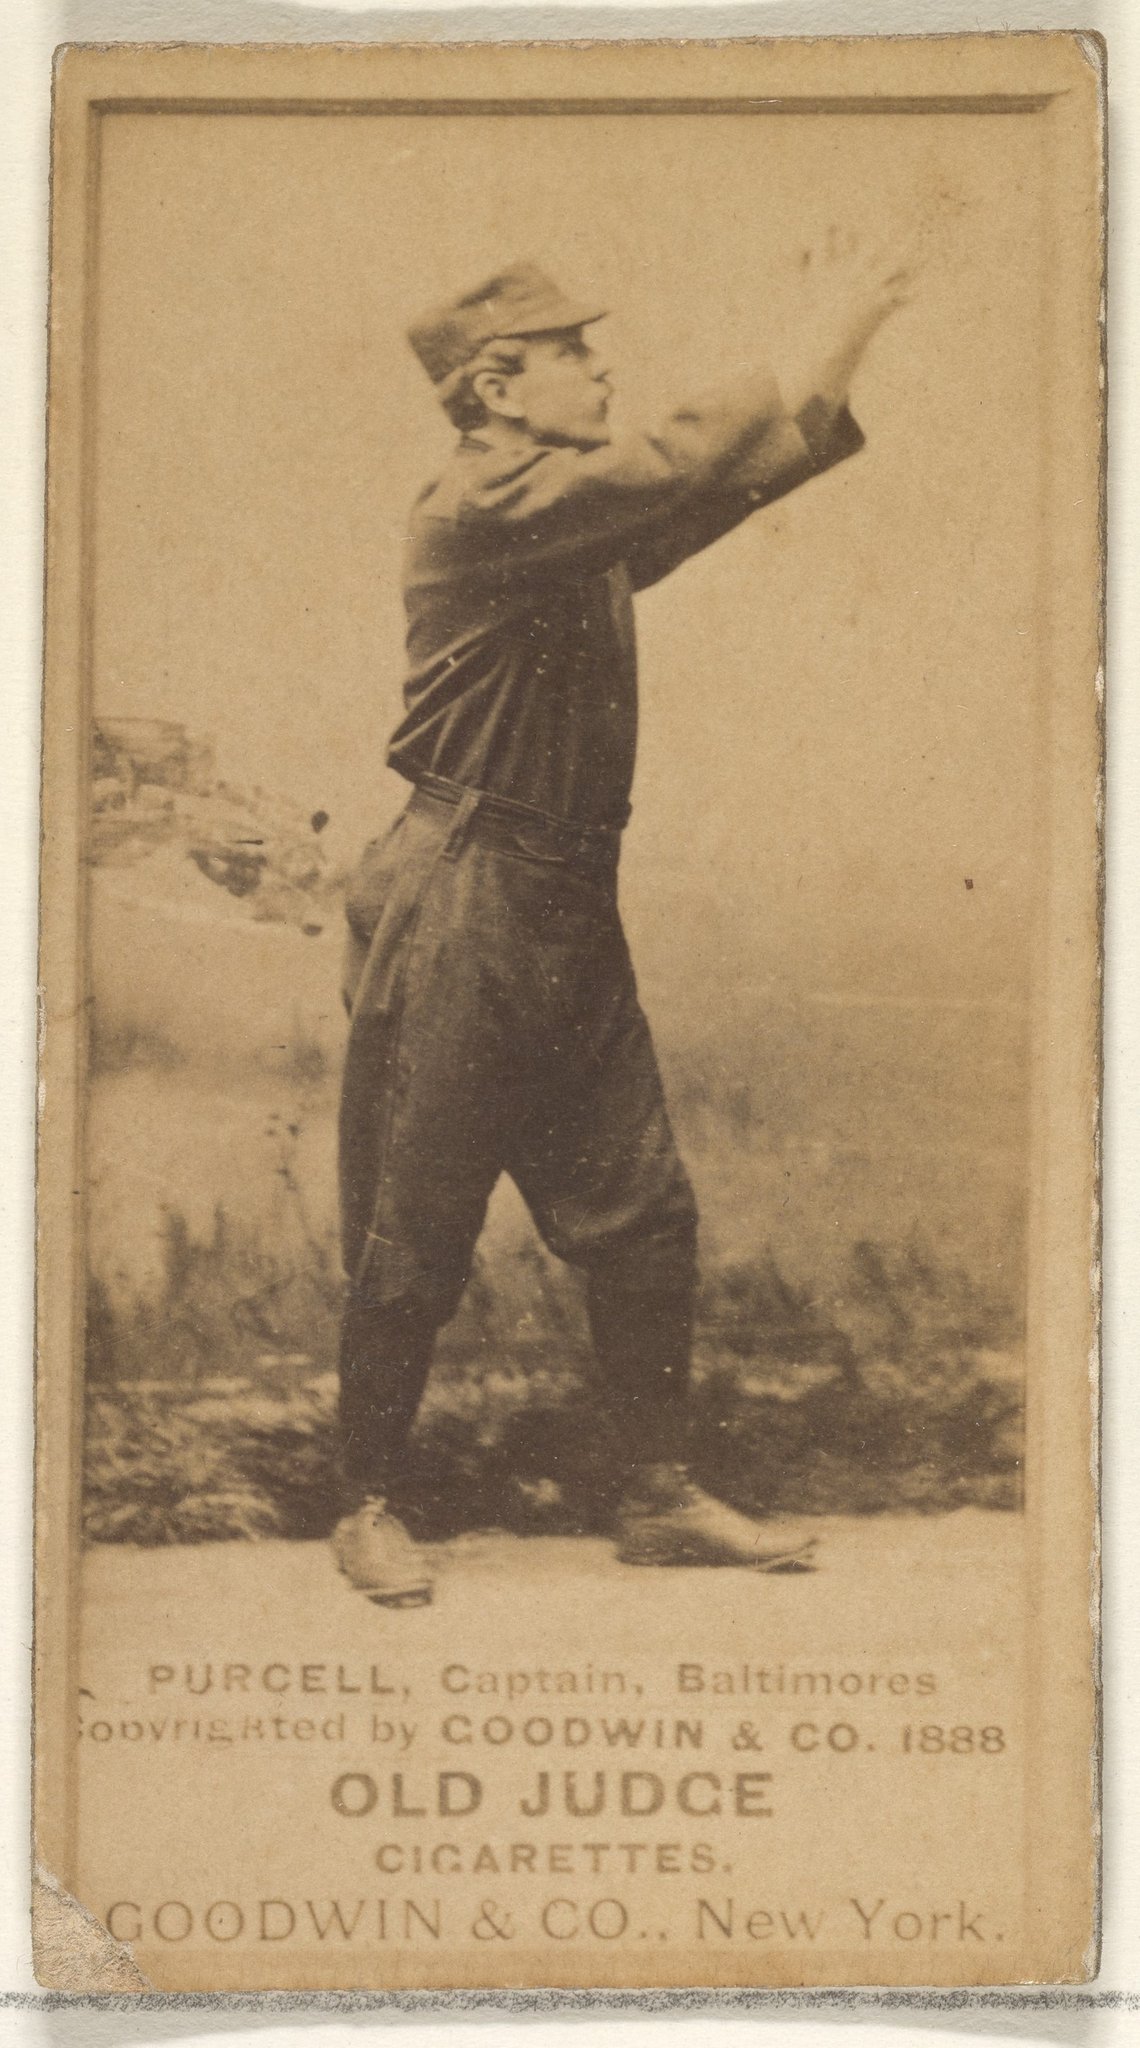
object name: baseball card, photograph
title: Purcell, Captain, Baltimore Orioles, from the Old Judge series (N172) for Old Judge Cigarettes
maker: goodwin & company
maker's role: publisher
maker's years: 1850-1950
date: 1888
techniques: albumen silver print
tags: men,portraits,baseball,athletes